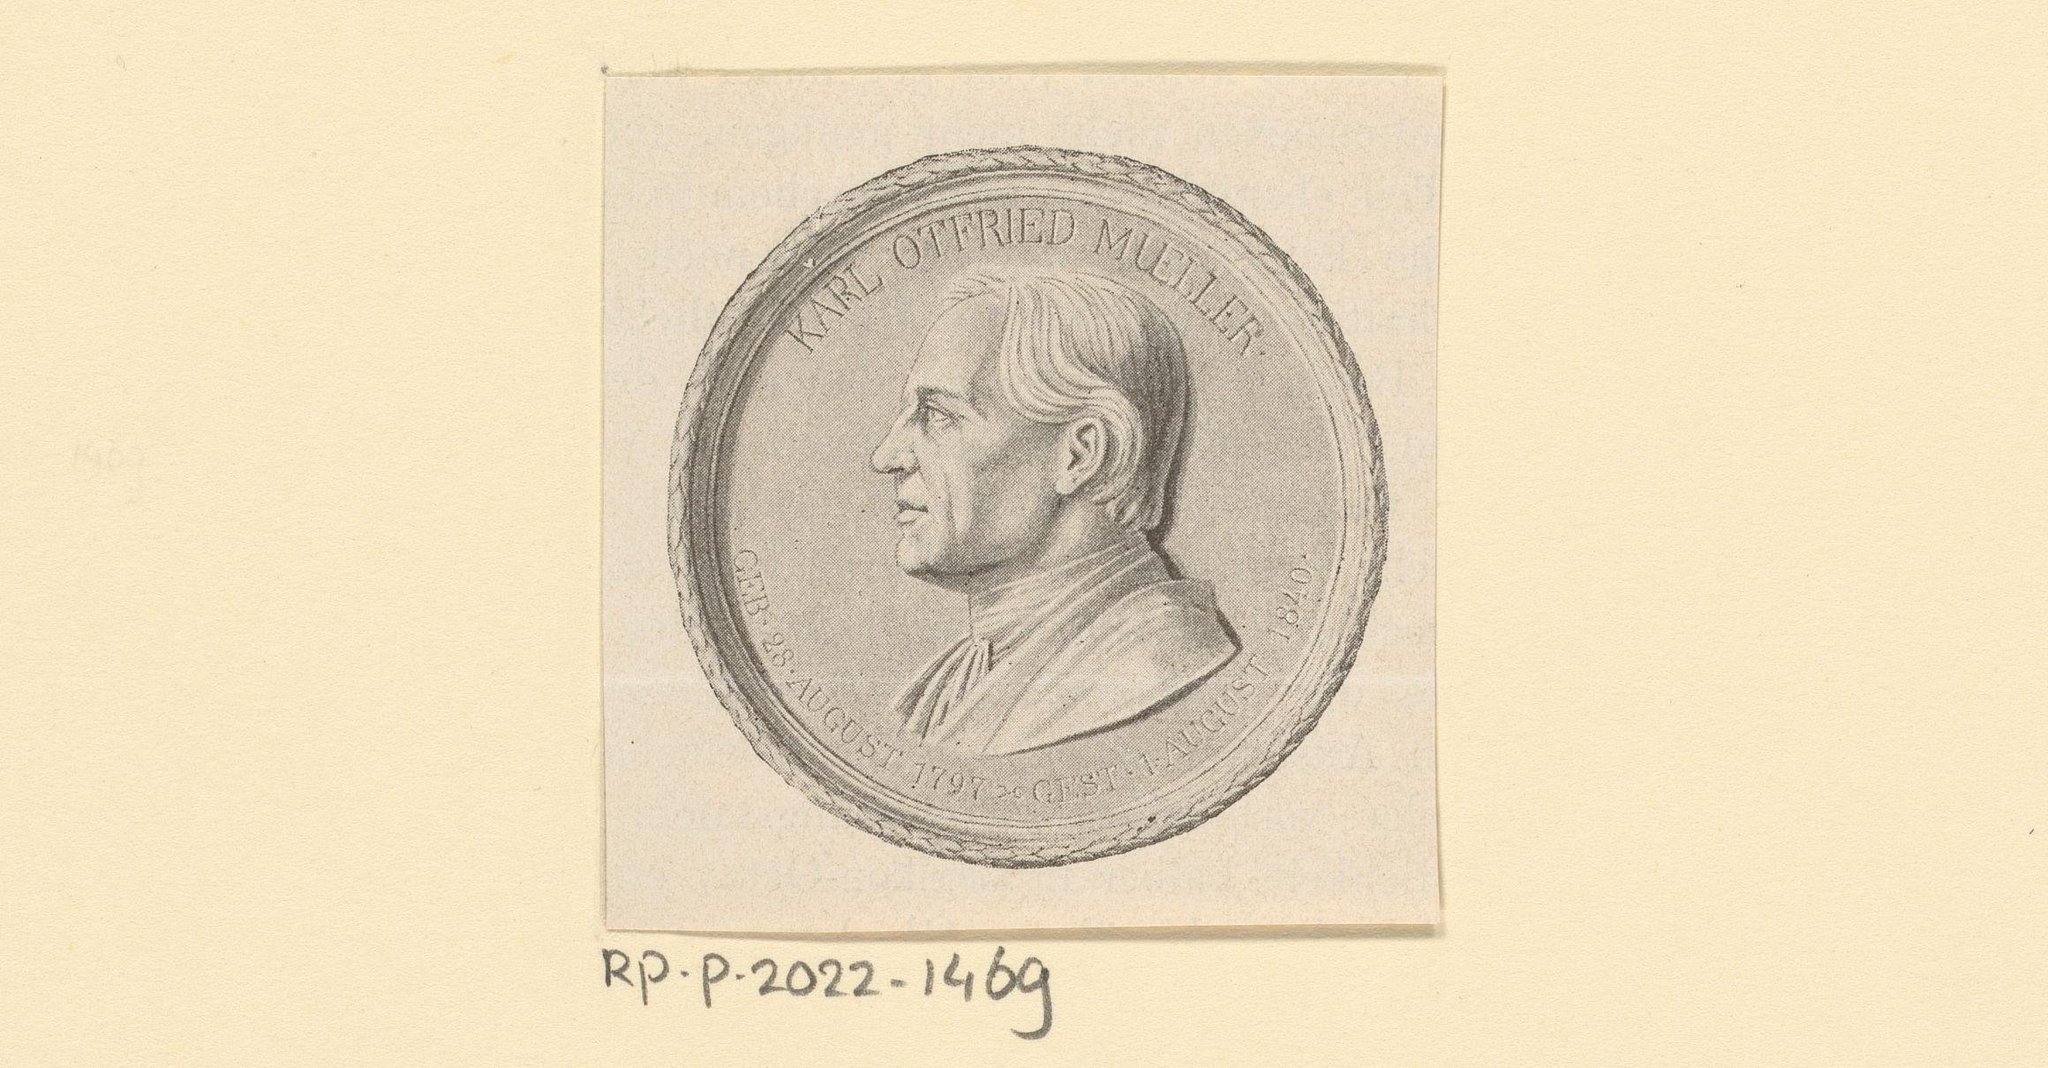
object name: photomechanical print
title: Portret van Karl Otfried Müller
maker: Anonymous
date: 1882-1970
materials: paper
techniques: letterpress printing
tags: scholar, philosopher, historical persons